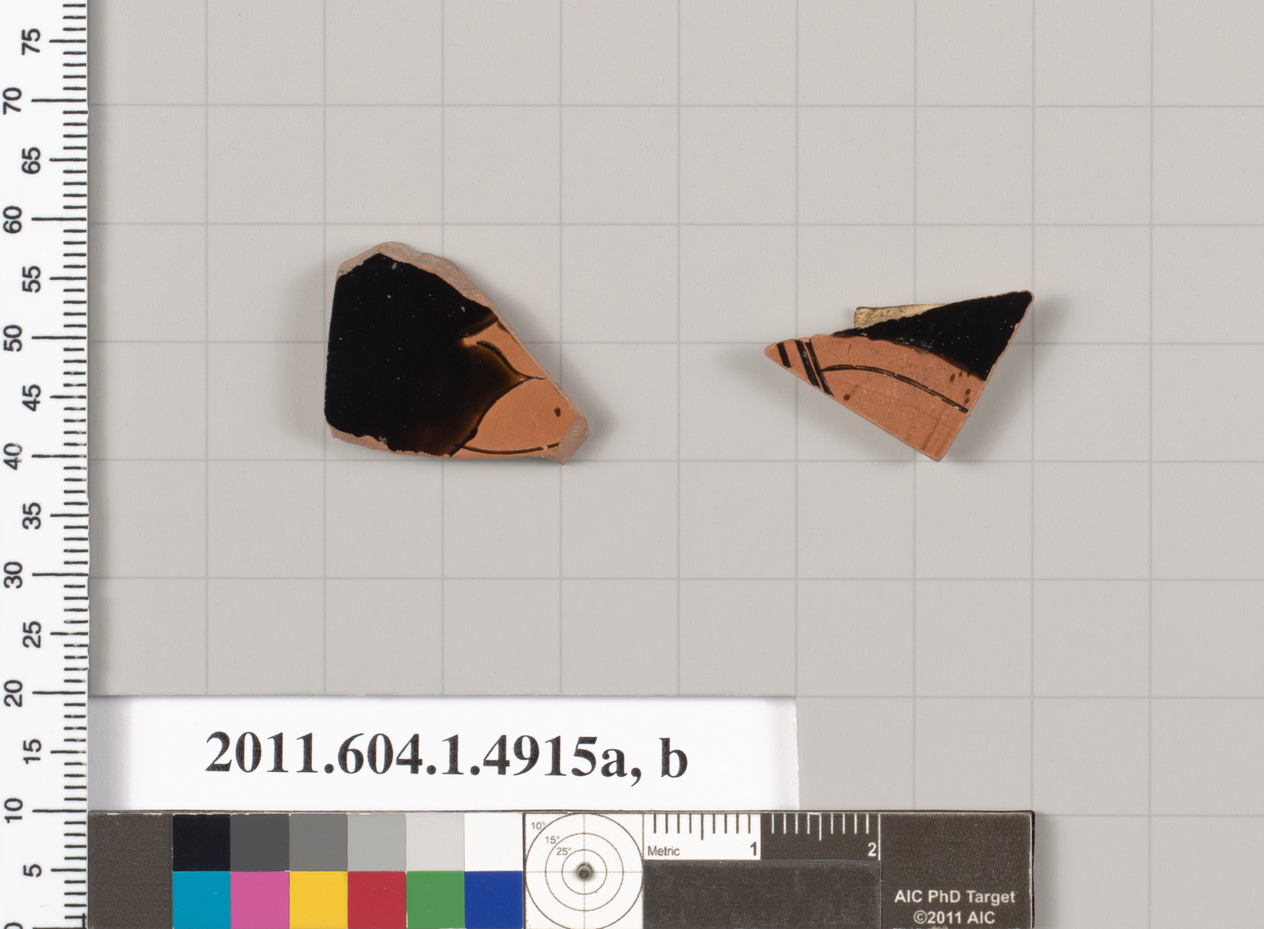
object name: kylix fragment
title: Terracotta fragments of kylikes (drinking cups)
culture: greek, attic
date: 600-401 BCE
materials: terracotta